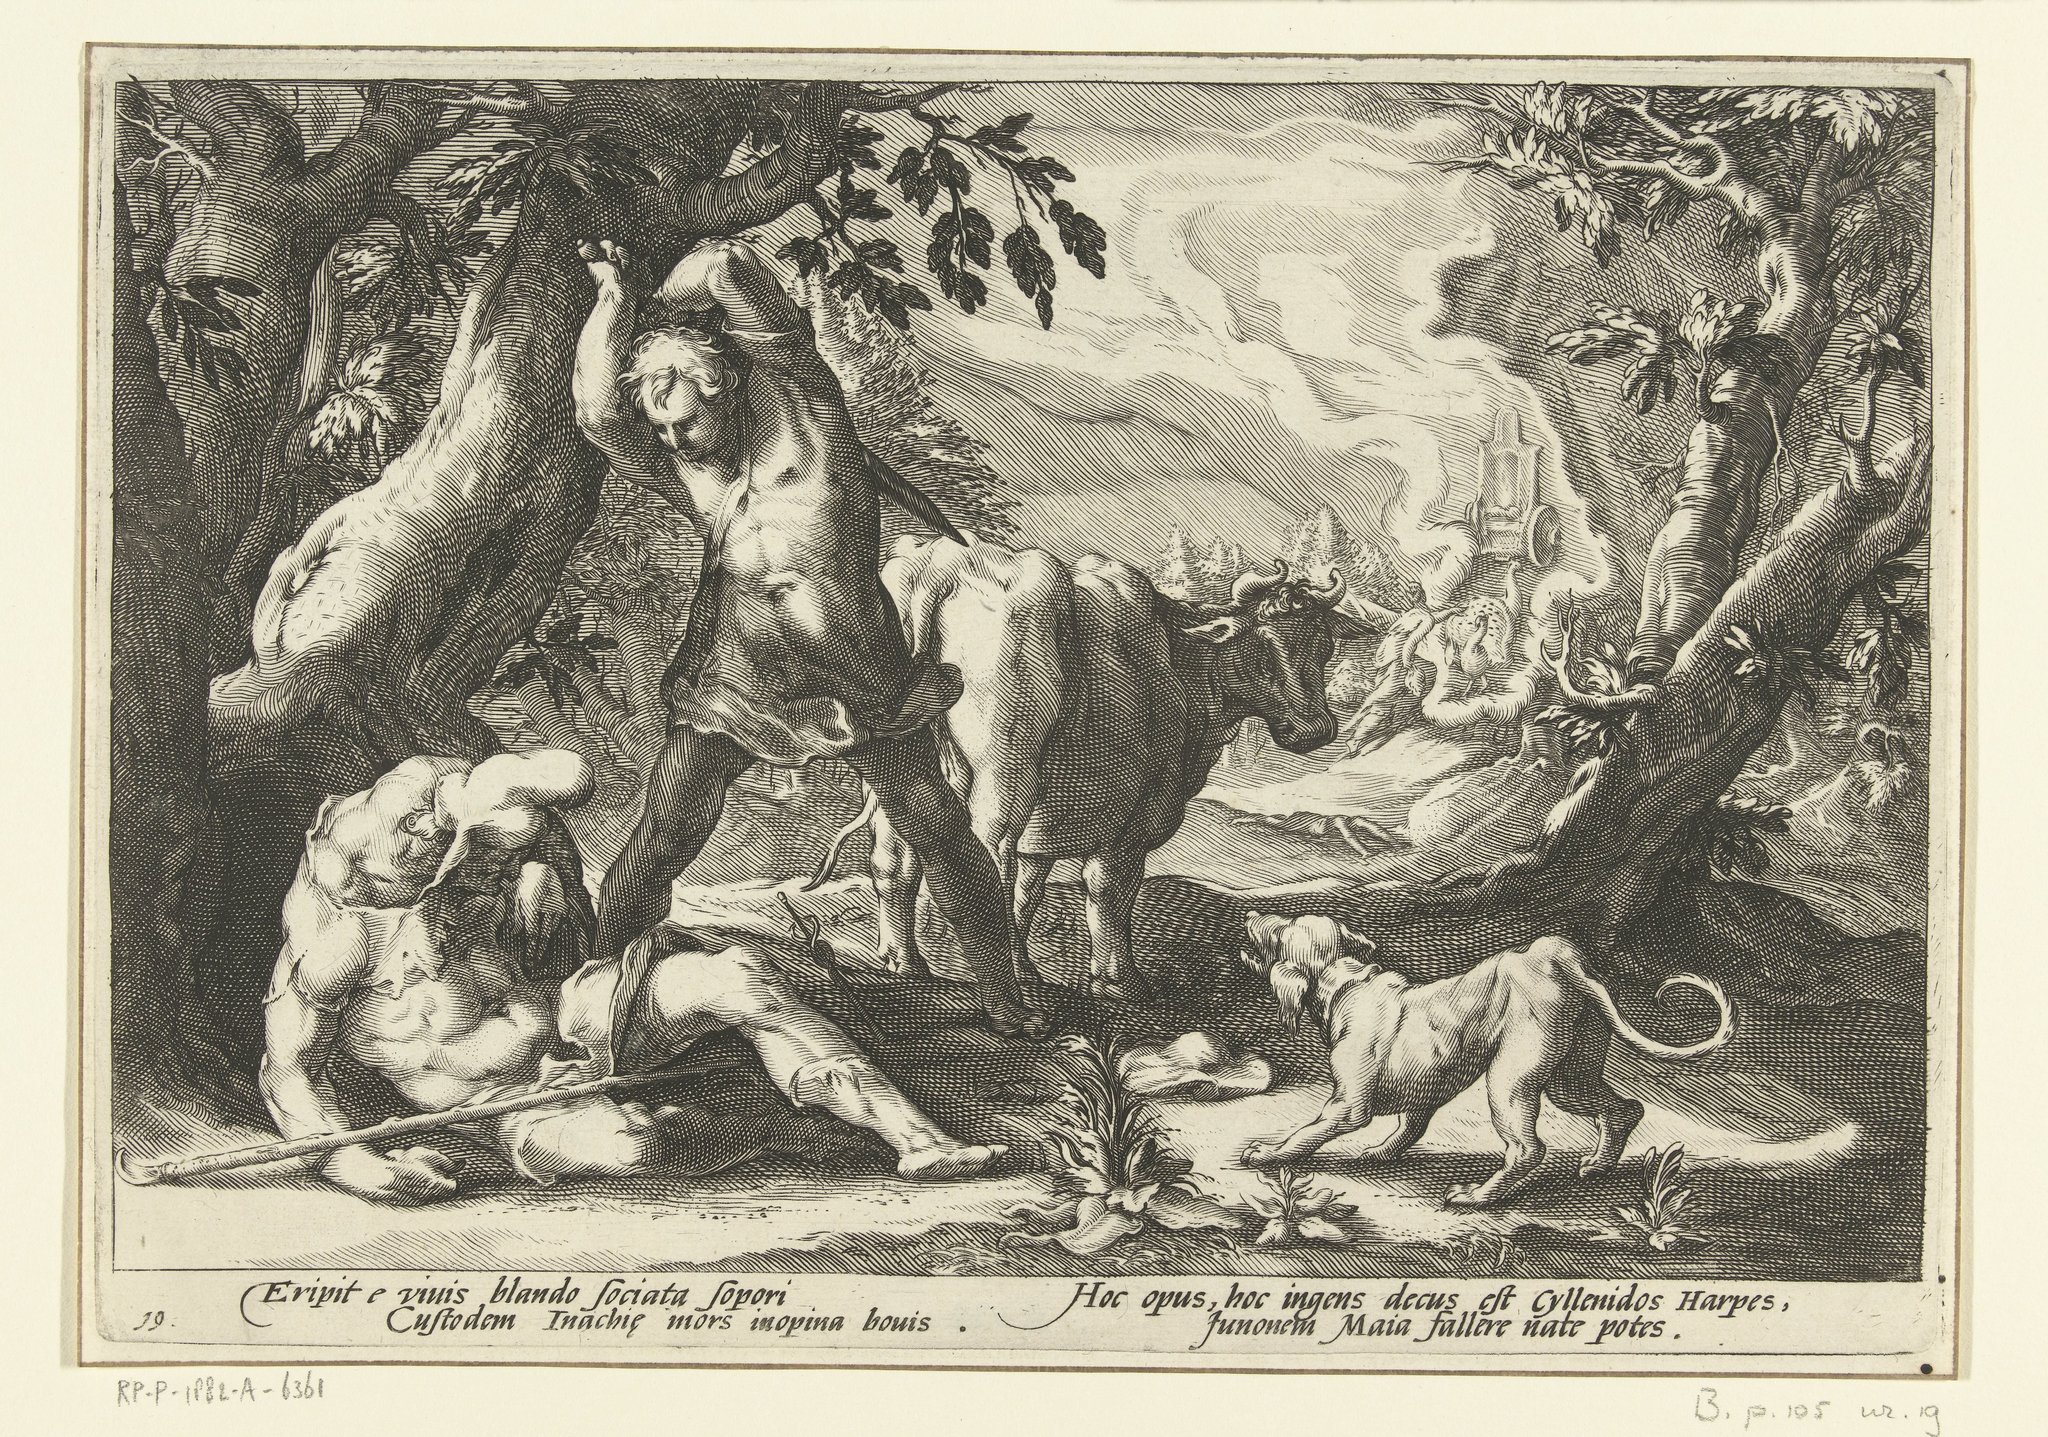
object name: print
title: Mercurius doodt Argus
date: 1589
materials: paper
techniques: engraving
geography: haarlem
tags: mercury beheads argus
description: Nadat hij hem in slaap gespeeld heeft met zijn fluit, doodt Mercurius de honderdogige Argus, die in opdracht van Juno de koe Io bewaakte. Onder de voorstelling twee keer twee regels Latijnse tekst. Deze prent is onderdeel van een serie van 52 prenten die verhalen uit Ovidius' Metamorfosen verbeelden. Deze serie valt uiteen in drie genummerde reeksen: twee van 20 prenten en één van 12 prenten. Deze prent behoort tot de eerste reeks.